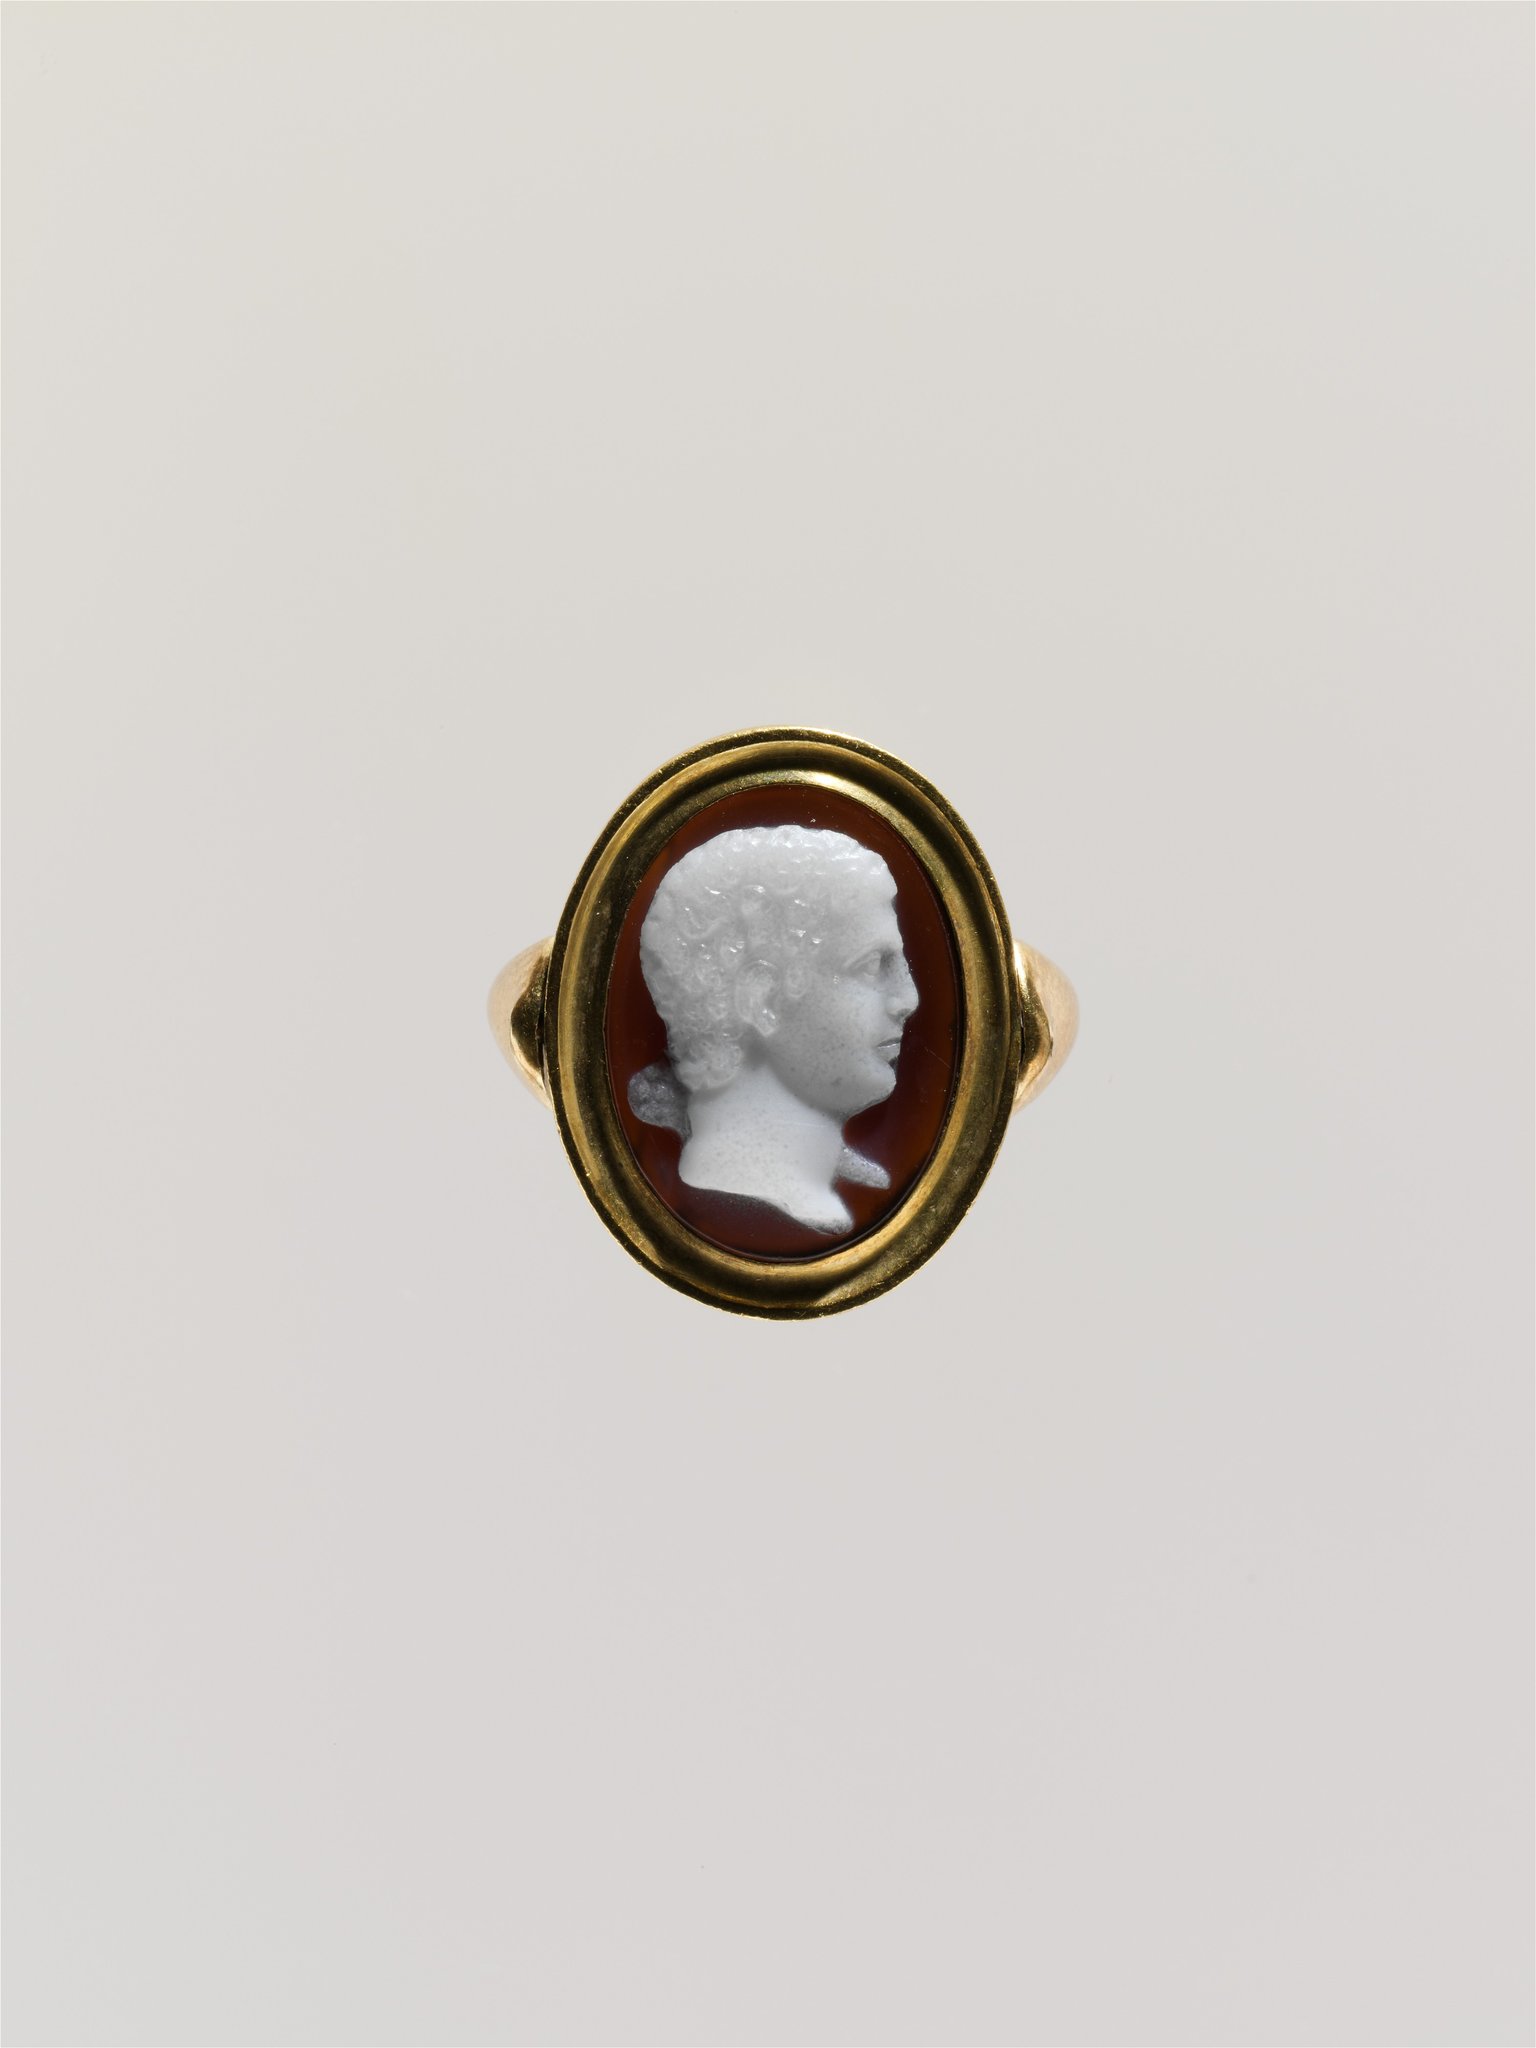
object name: cameo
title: Head of young Hercules and the Nemean lion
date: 1767-1833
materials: gold, gemstone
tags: profiles,hercules